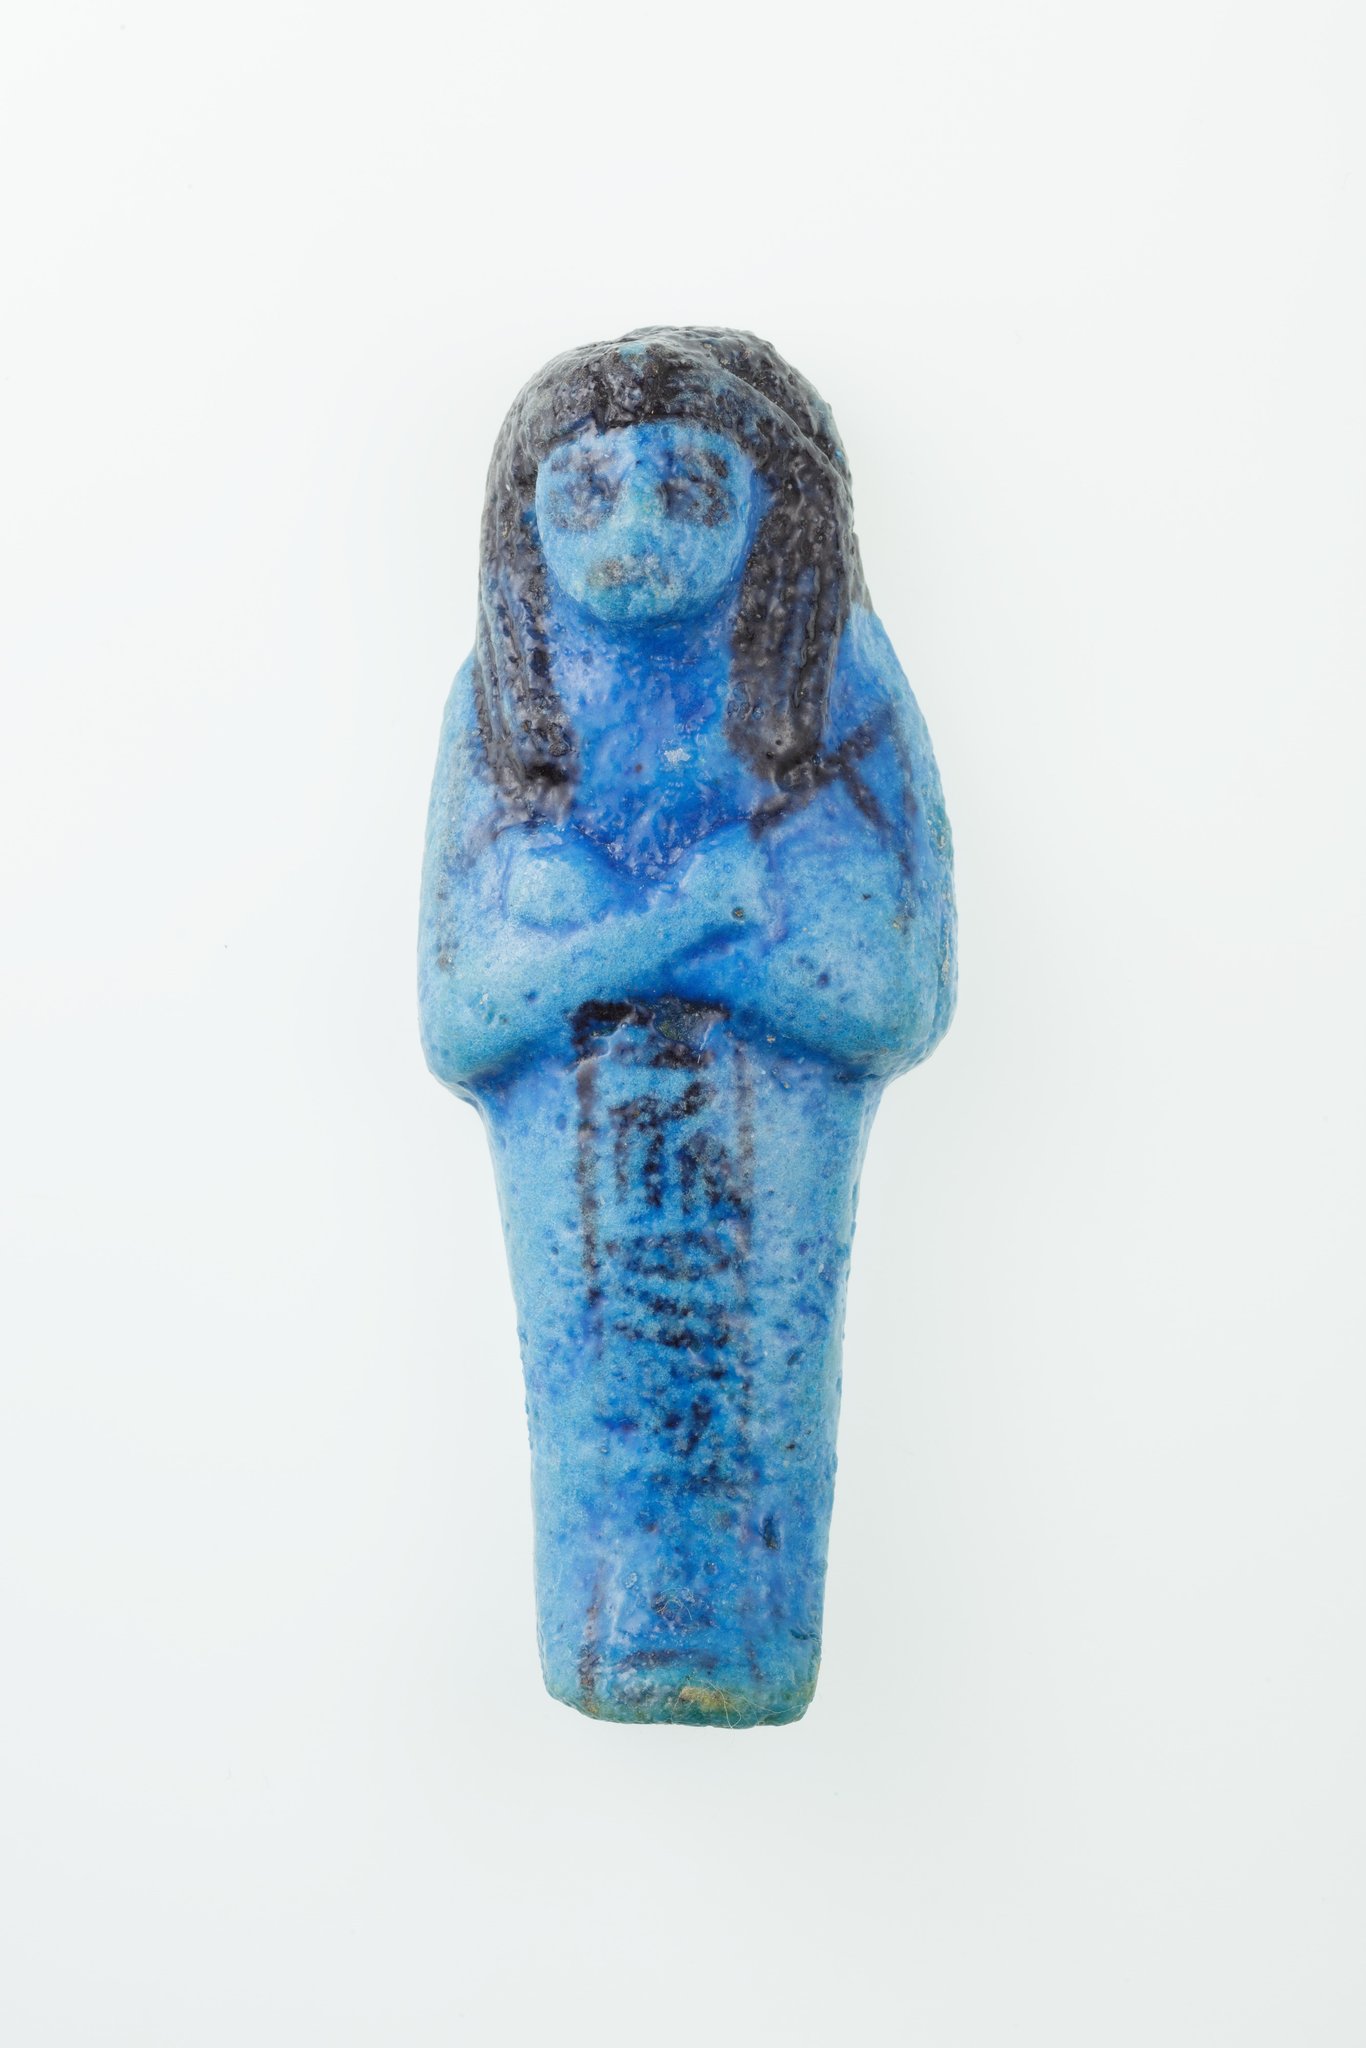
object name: shabti, worker, nauny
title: Worker Shabti of Nauny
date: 1050 BCE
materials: faience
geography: egypt